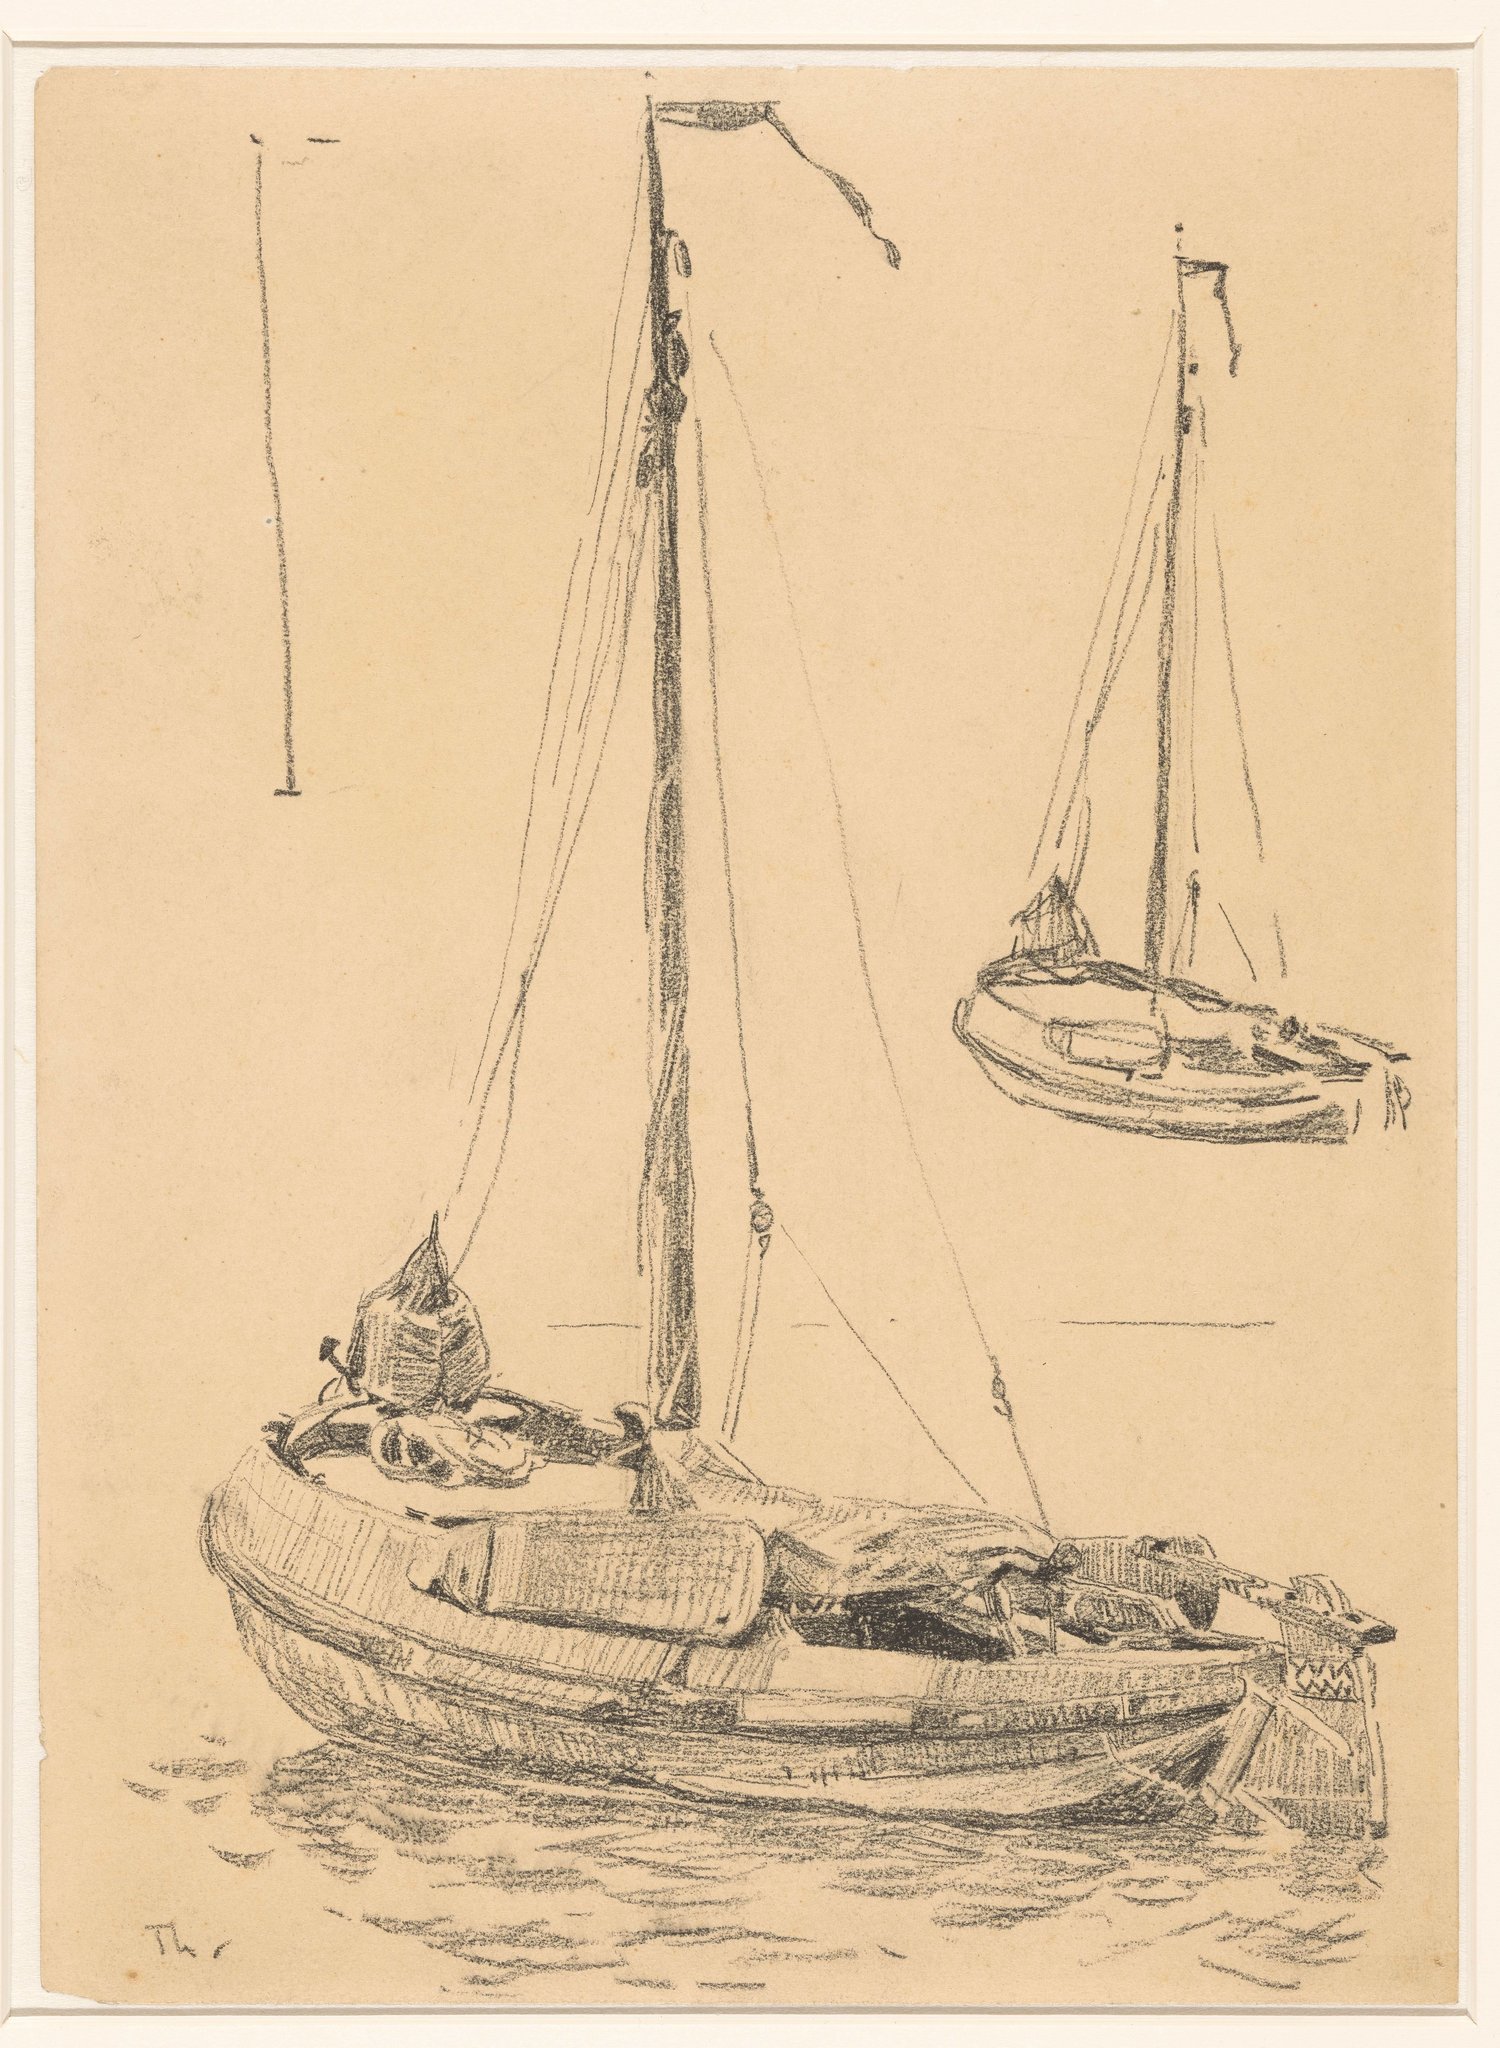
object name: drawing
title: Studieblad met twee boten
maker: willem bastiaan tholen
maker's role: draughtsman, painter, print maker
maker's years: 1860-1931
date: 1870-1931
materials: chalk, paper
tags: ships (in general) - cc - more than one ship